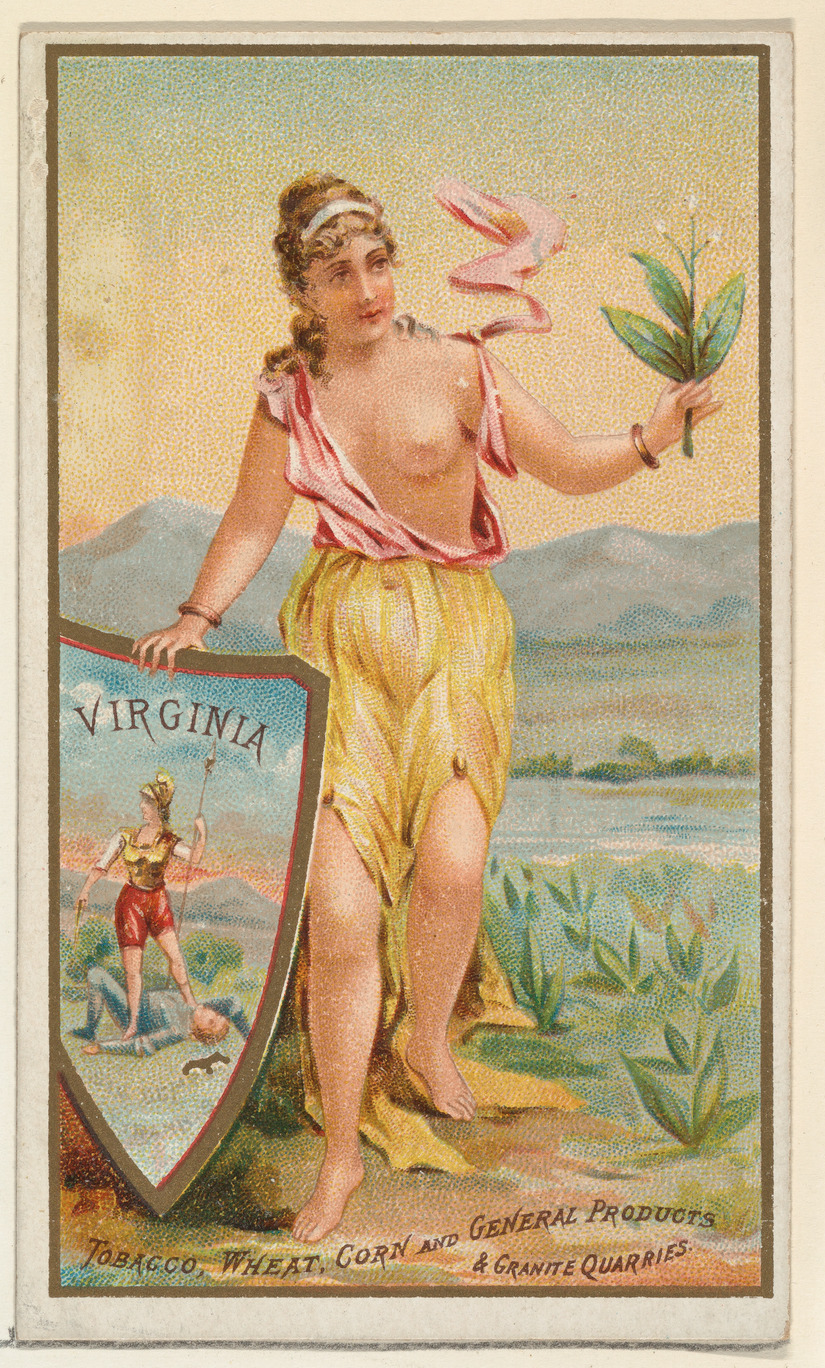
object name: print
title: Virginia, from the Industries of States series (N117) issued by Duke Sons & Co. to promote Honest Long Cut Tobacco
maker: w. duke, sons & co.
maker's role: publisher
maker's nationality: american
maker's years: 1870-1920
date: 1889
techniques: color lithograph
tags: shields,women,female nudes